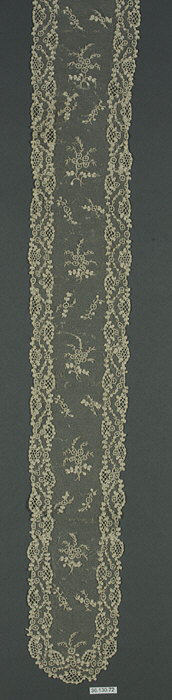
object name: lappet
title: Lappet (one of a pair)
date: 1701-1800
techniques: lace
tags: flowers